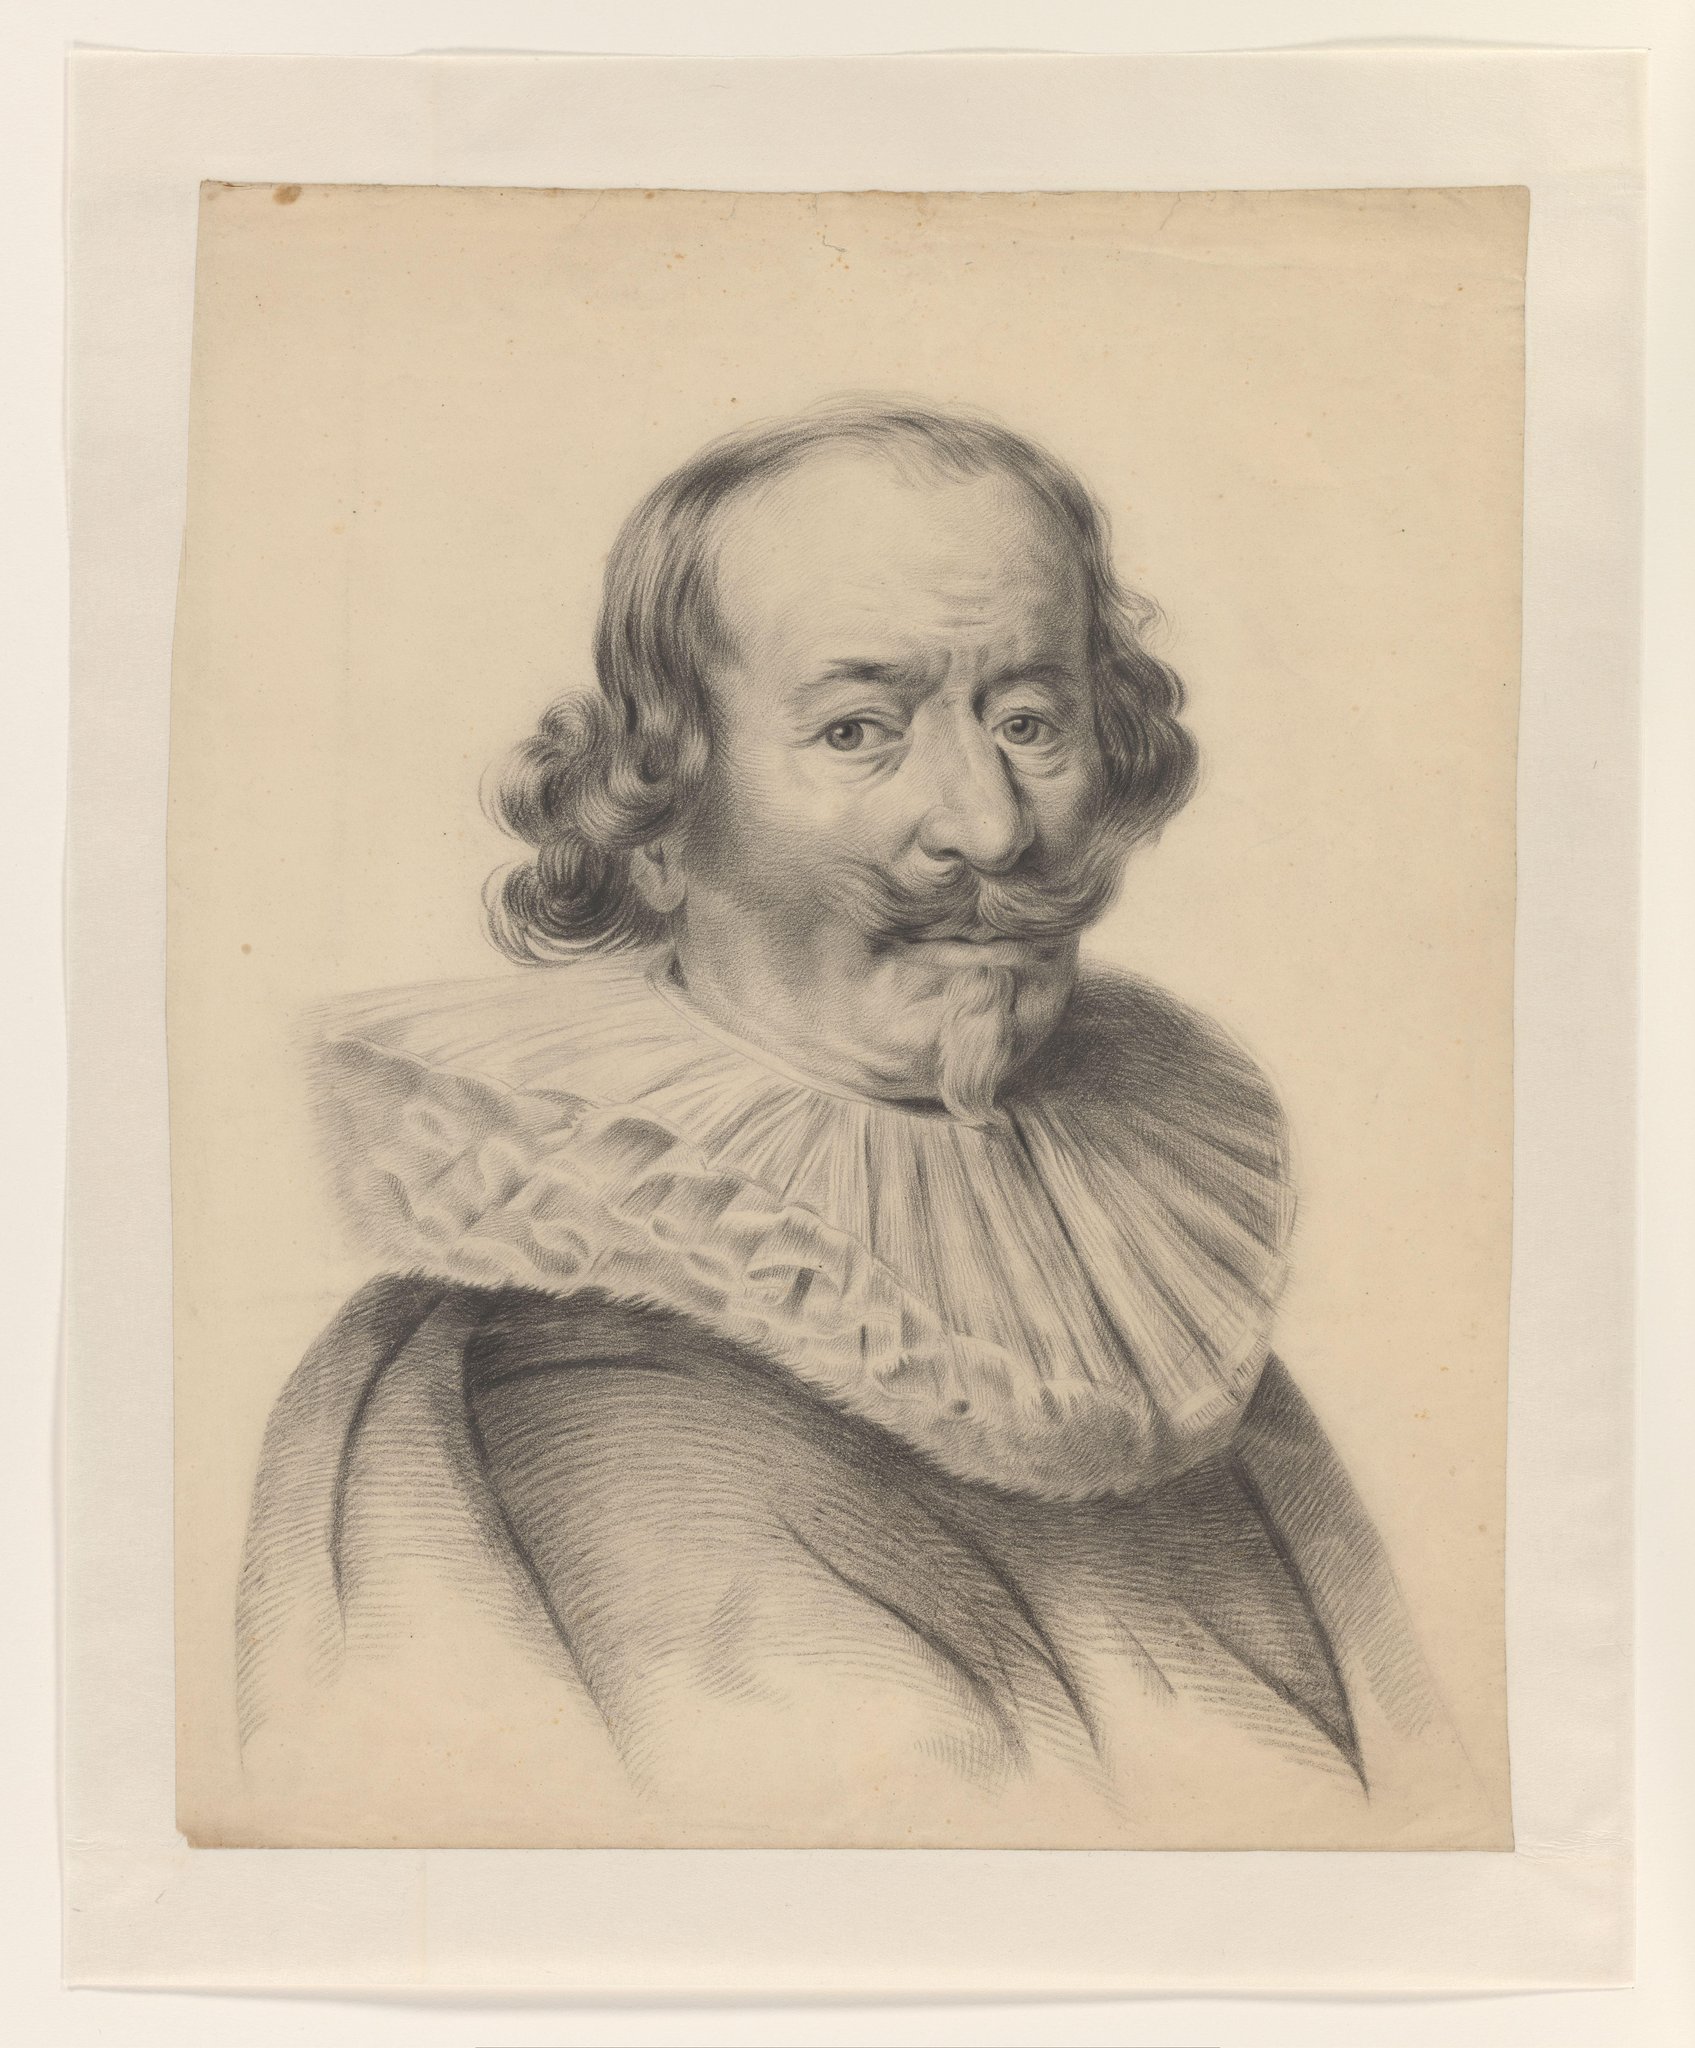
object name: drawing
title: Portret van een zeventiende-eeuwse man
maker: s.a. van der heim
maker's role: draughtsman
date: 1821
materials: chalk, paper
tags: anonymous historical person portrayed alone